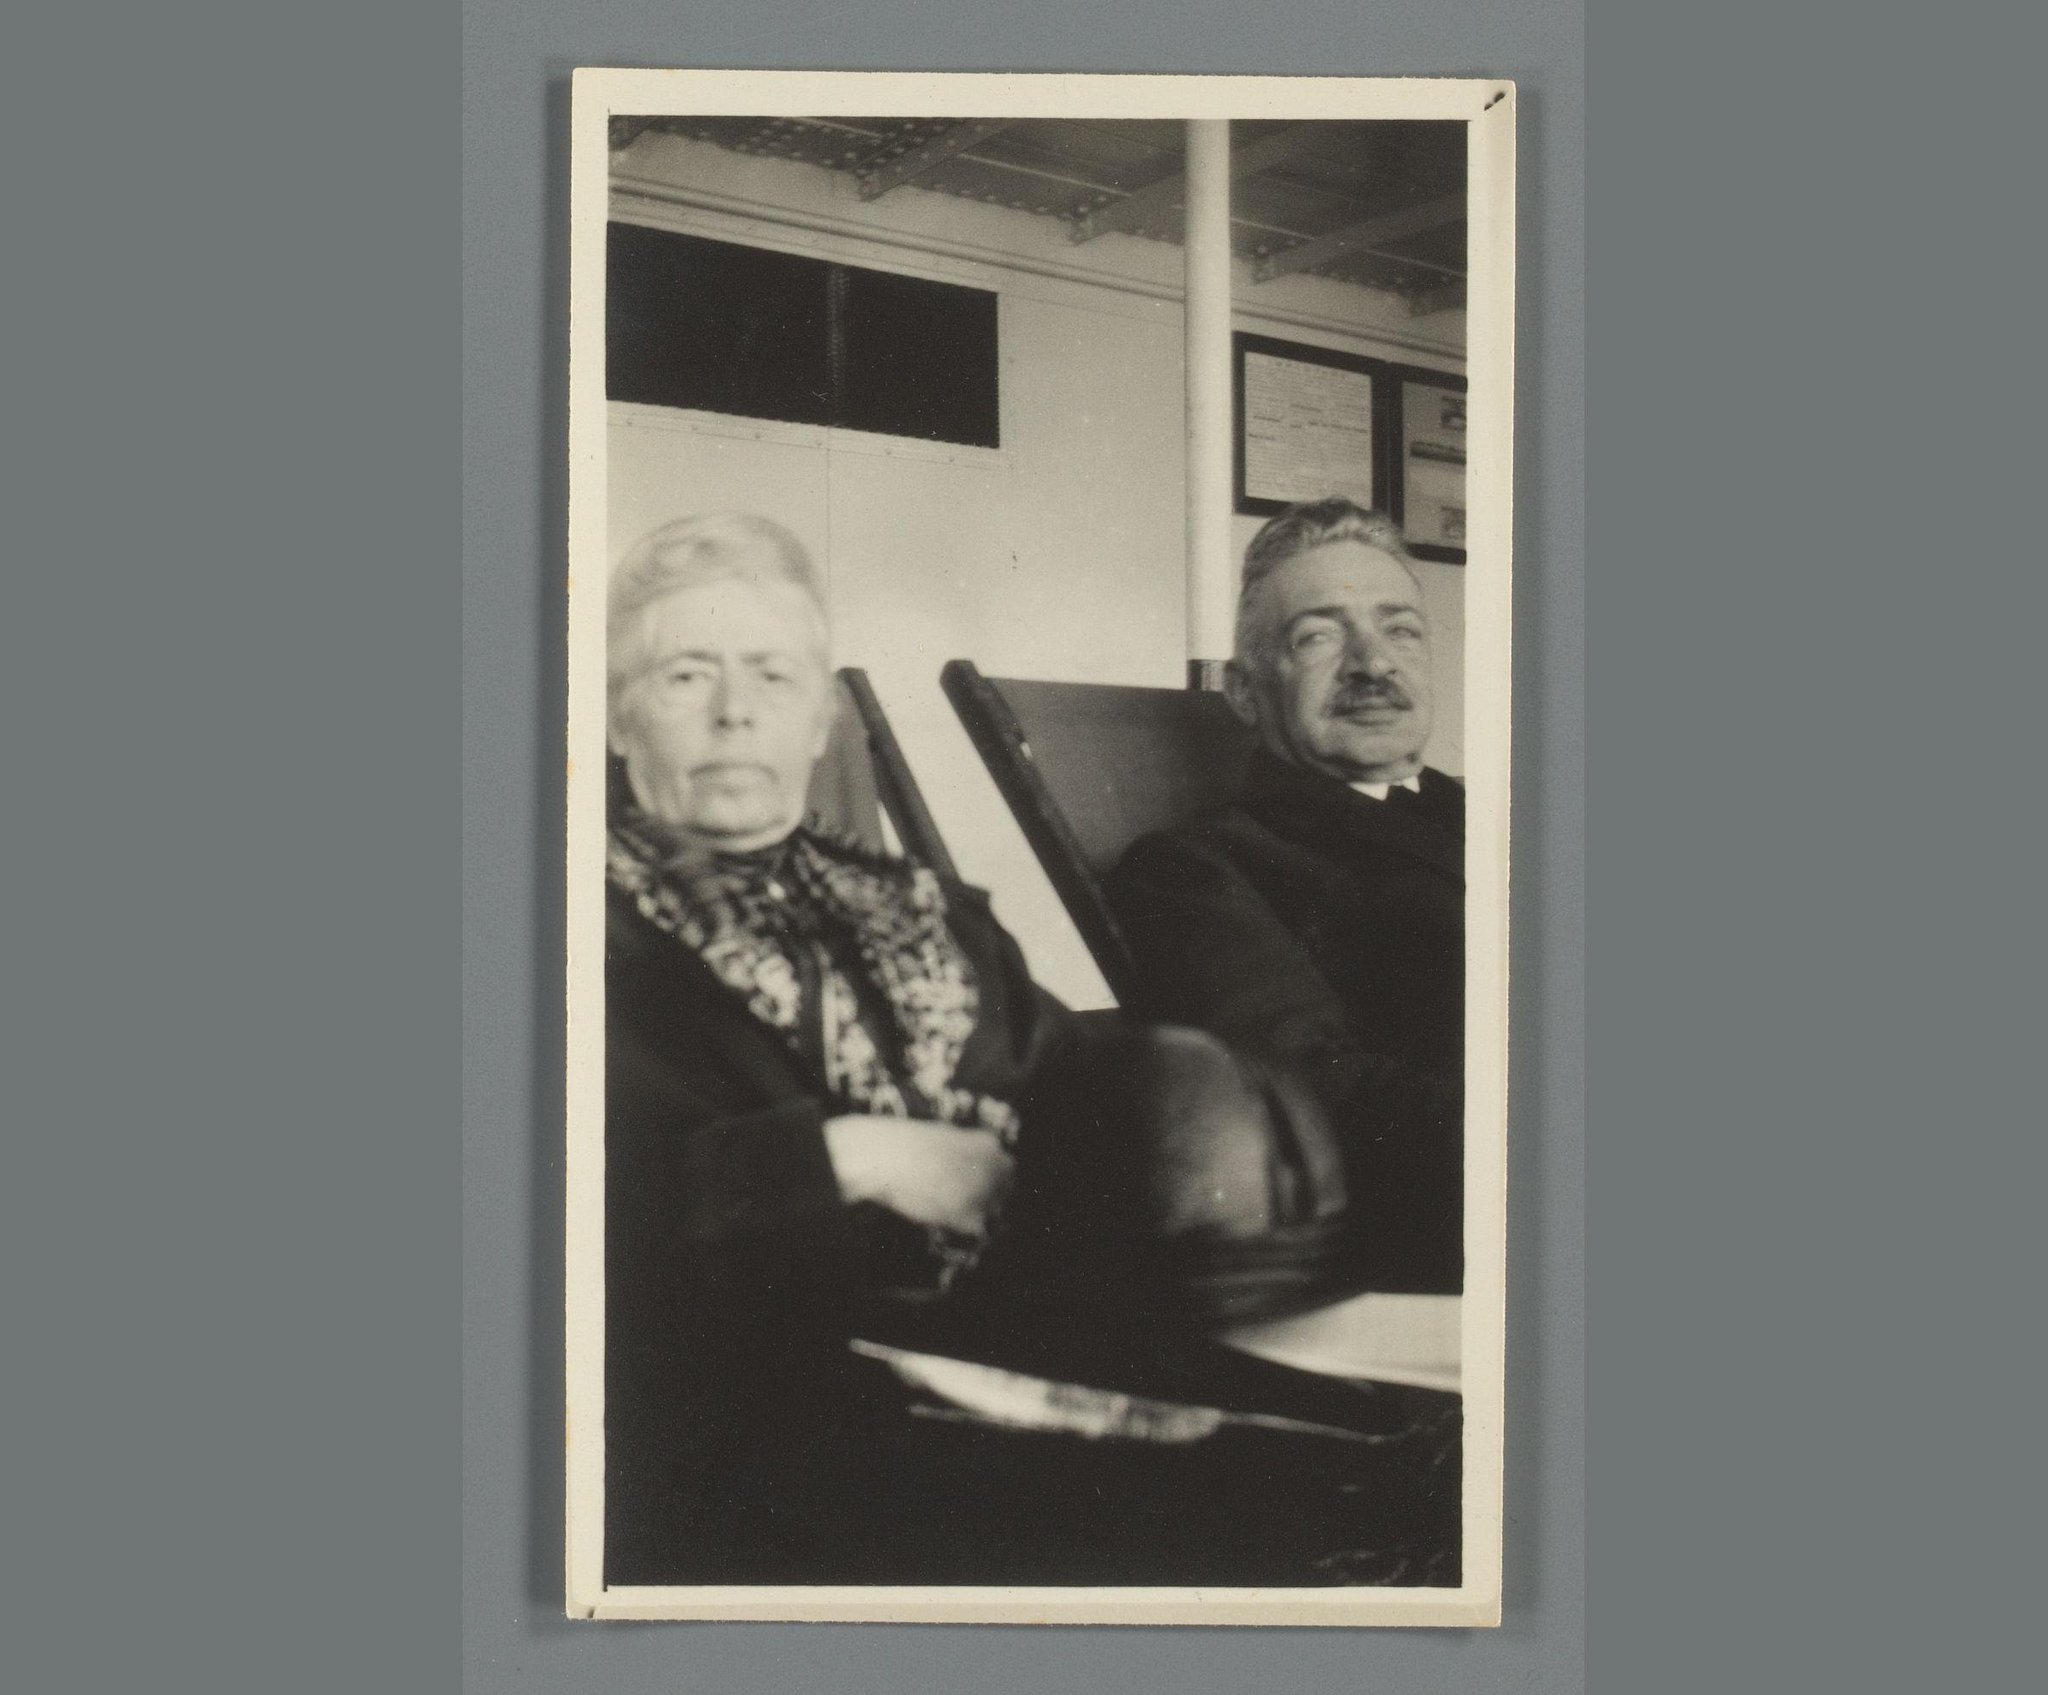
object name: photograph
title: Portret van een onbekende oudere man en vrouw aan boord van het schip Zeeland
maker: Anonymous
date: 1925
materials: paper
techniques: gelatin silver print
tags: old man, old woman, historical persons not known by name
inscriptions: inscription: ‘Dinsdag 28 Juli '25/ Aan boord van de/ Zeeland/ Browni[...]/ 425’